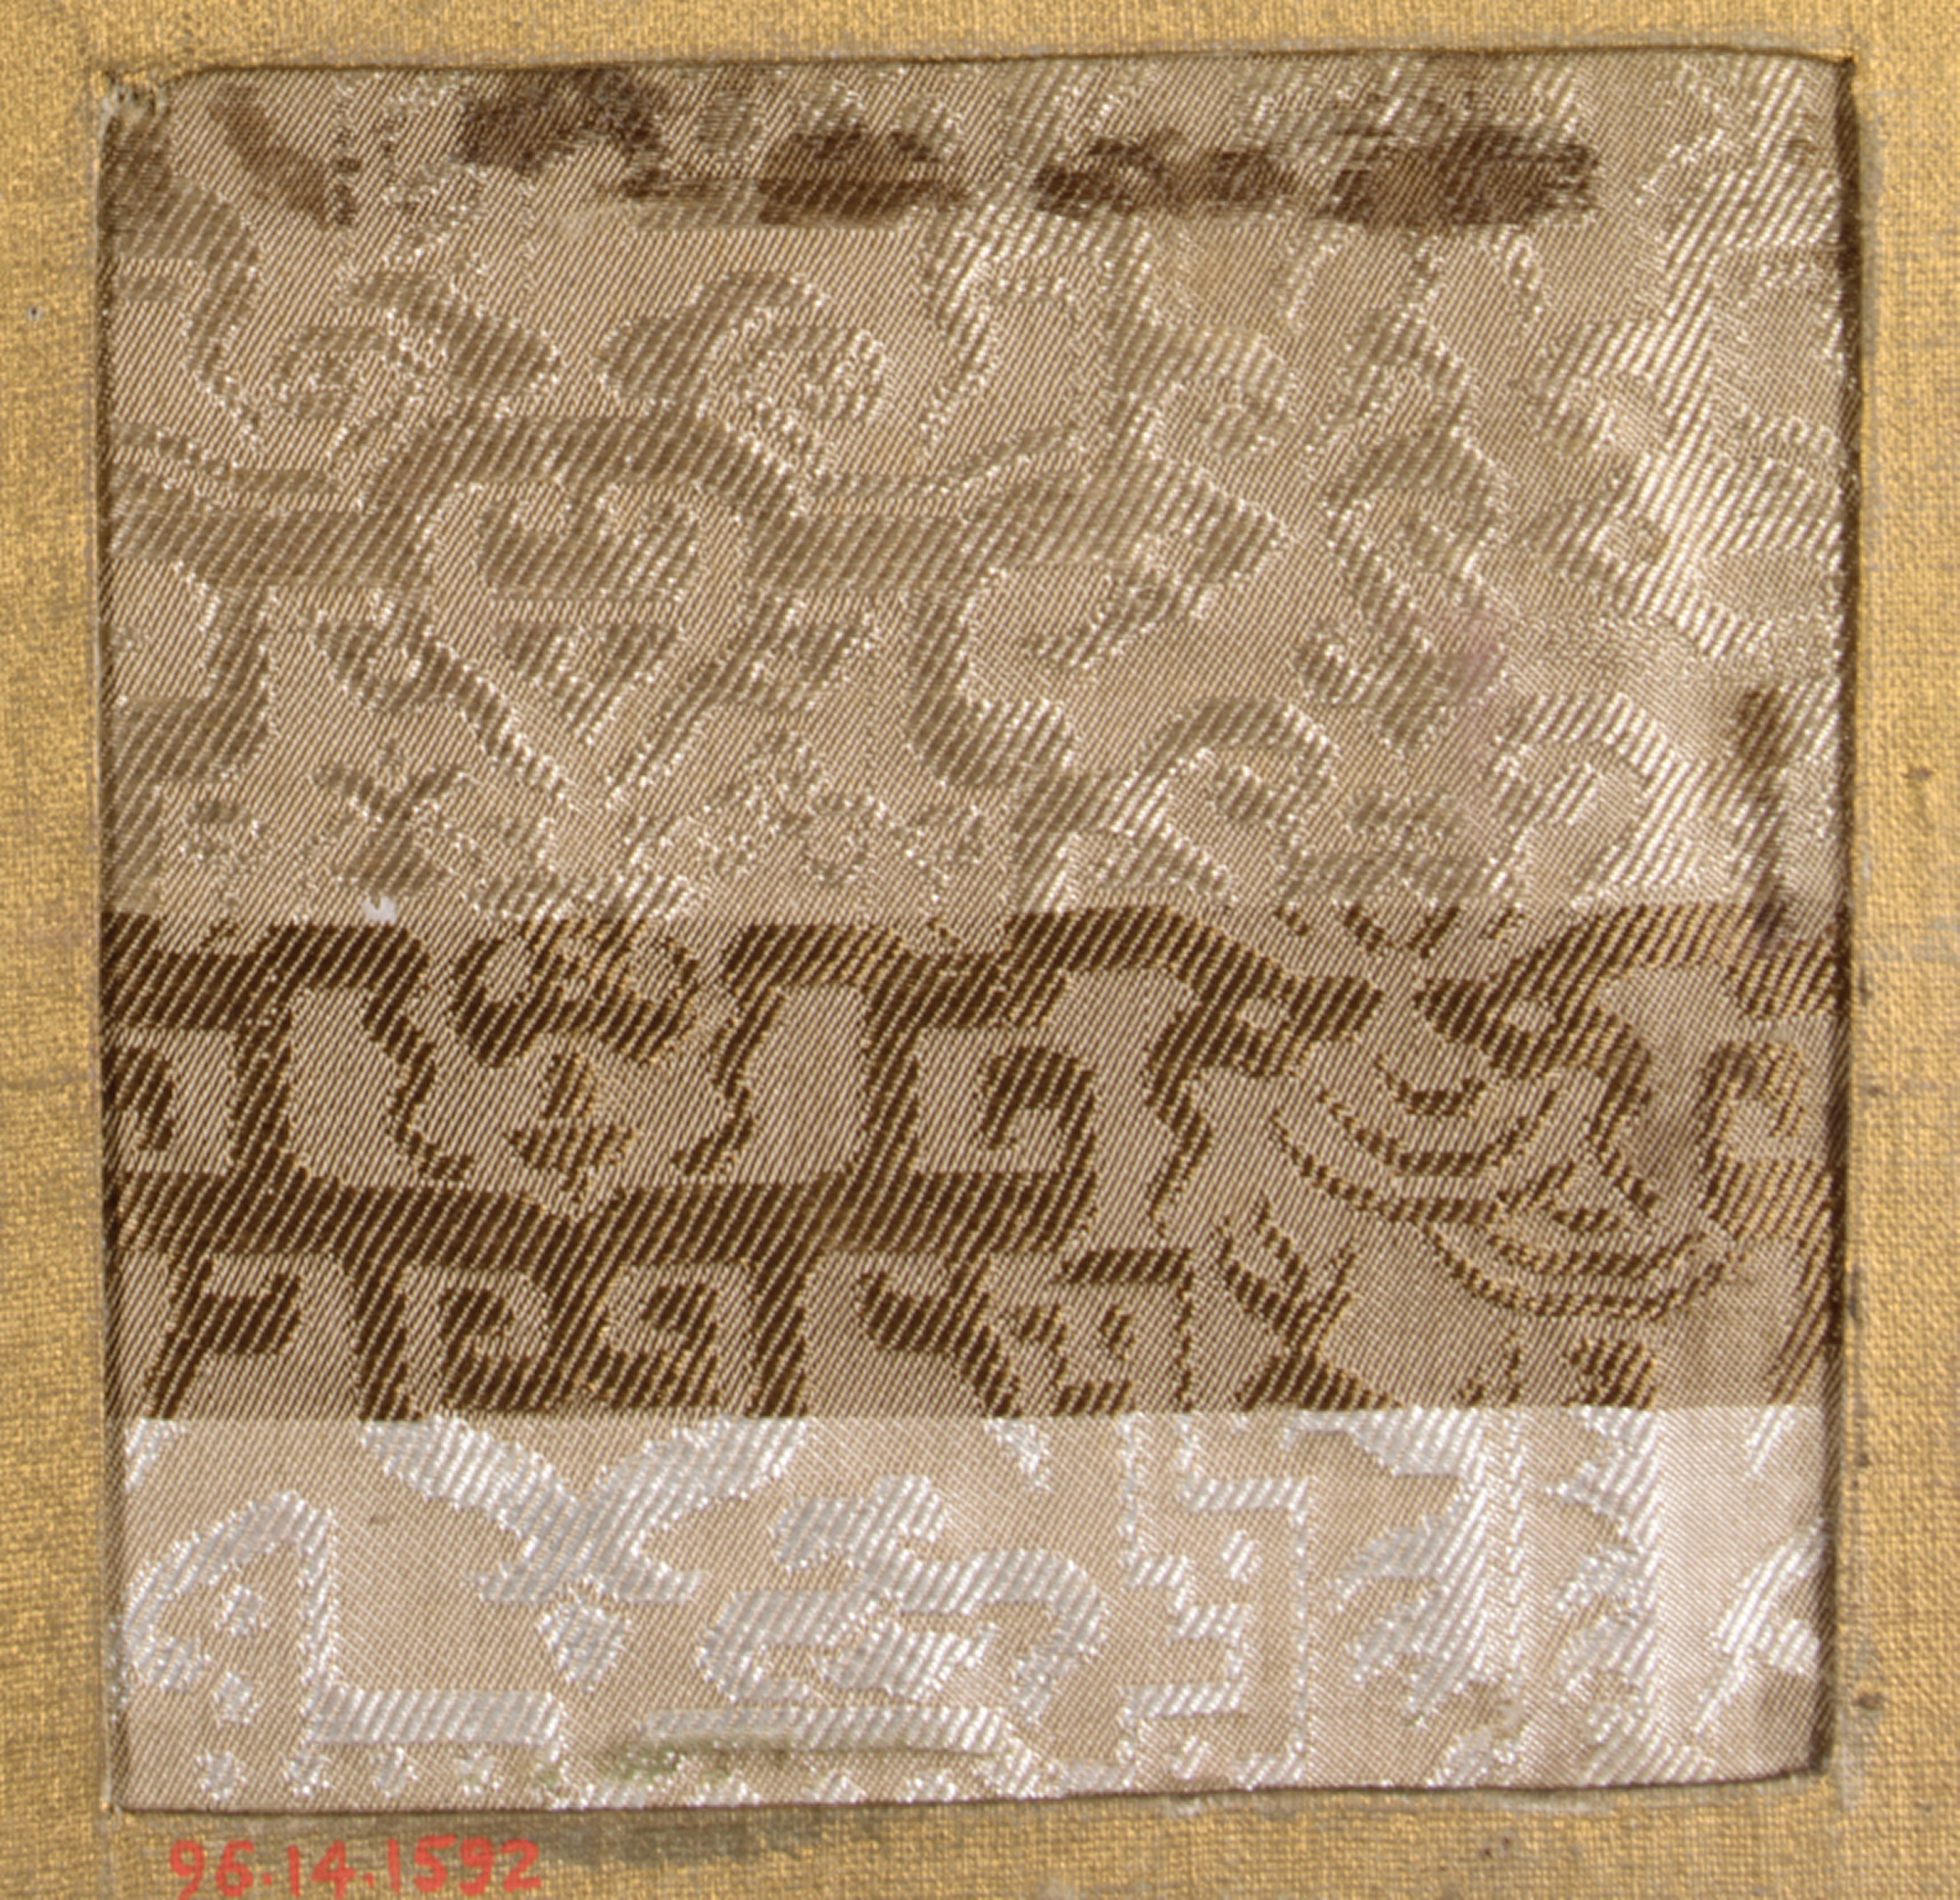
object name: piece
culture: japanese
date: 1701-1900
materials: silk